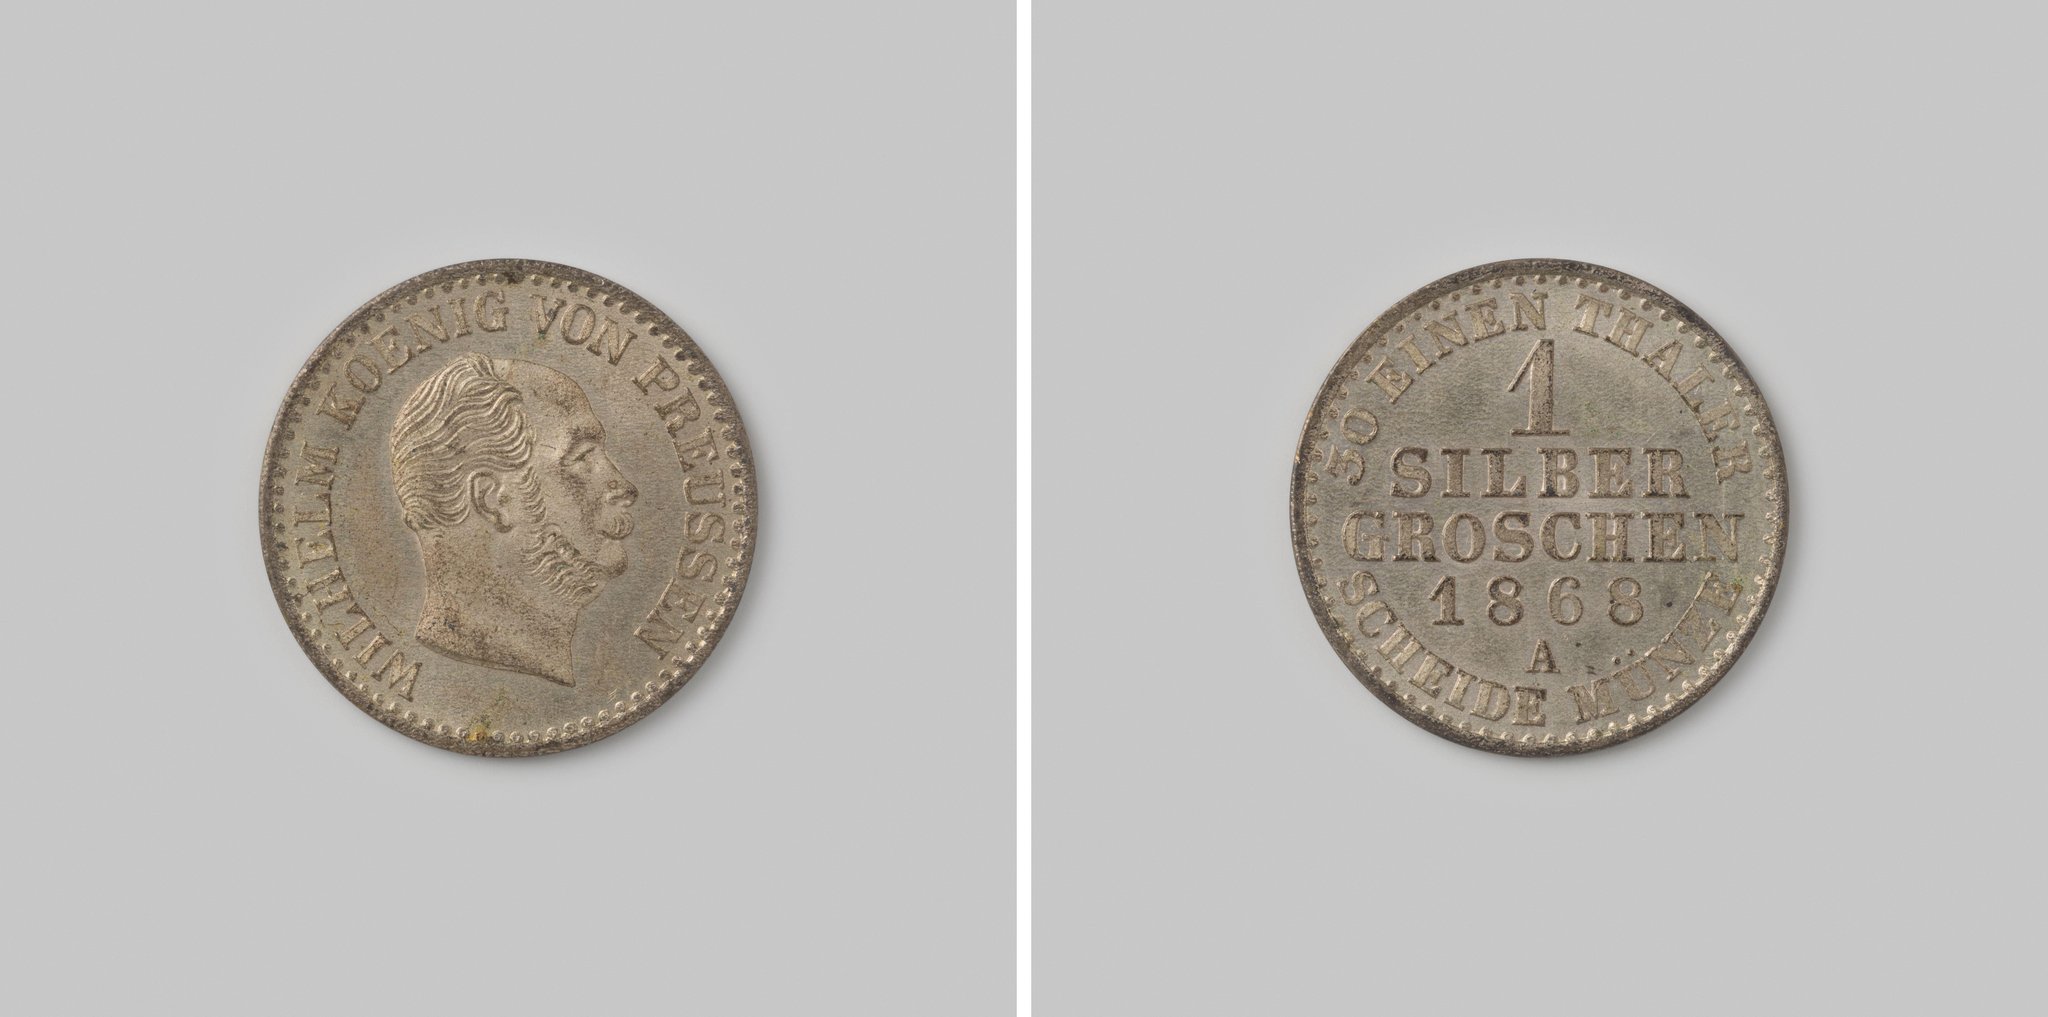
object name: coin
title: Silbergroschen uit Pruisen van Wilhelm I, 1868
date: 1868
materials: silver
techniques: striking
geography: berlin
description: Zilveren munt. Voorzijde: hoofd van de koning naar rechts. Keerzijde: Waarde-aanduiding in drie regels, waaronder jaartal. Daaronder letter A. Gladde rand.